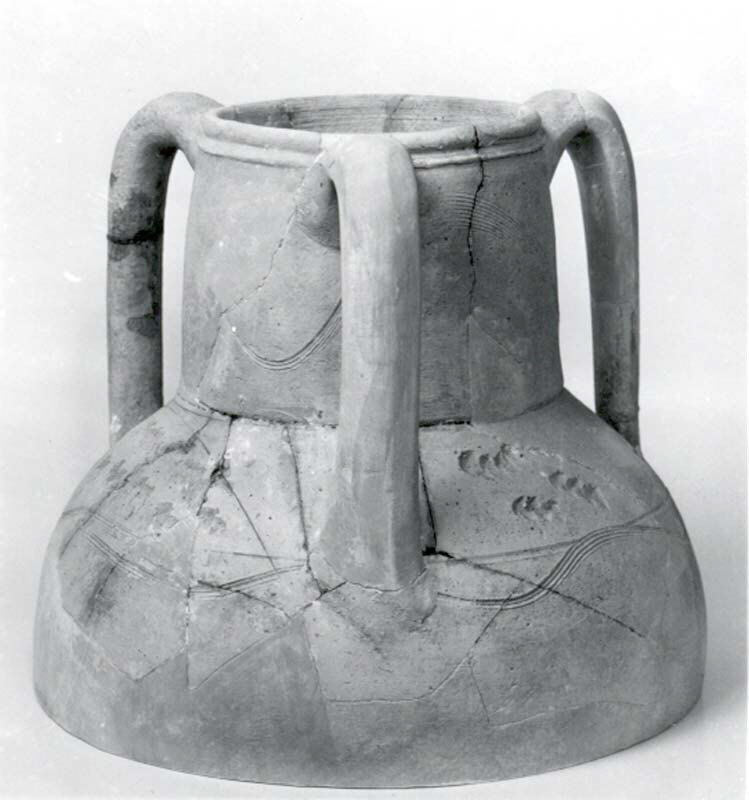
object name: jar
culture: sasanian or islamic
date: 501-800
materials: ceramic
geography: iran